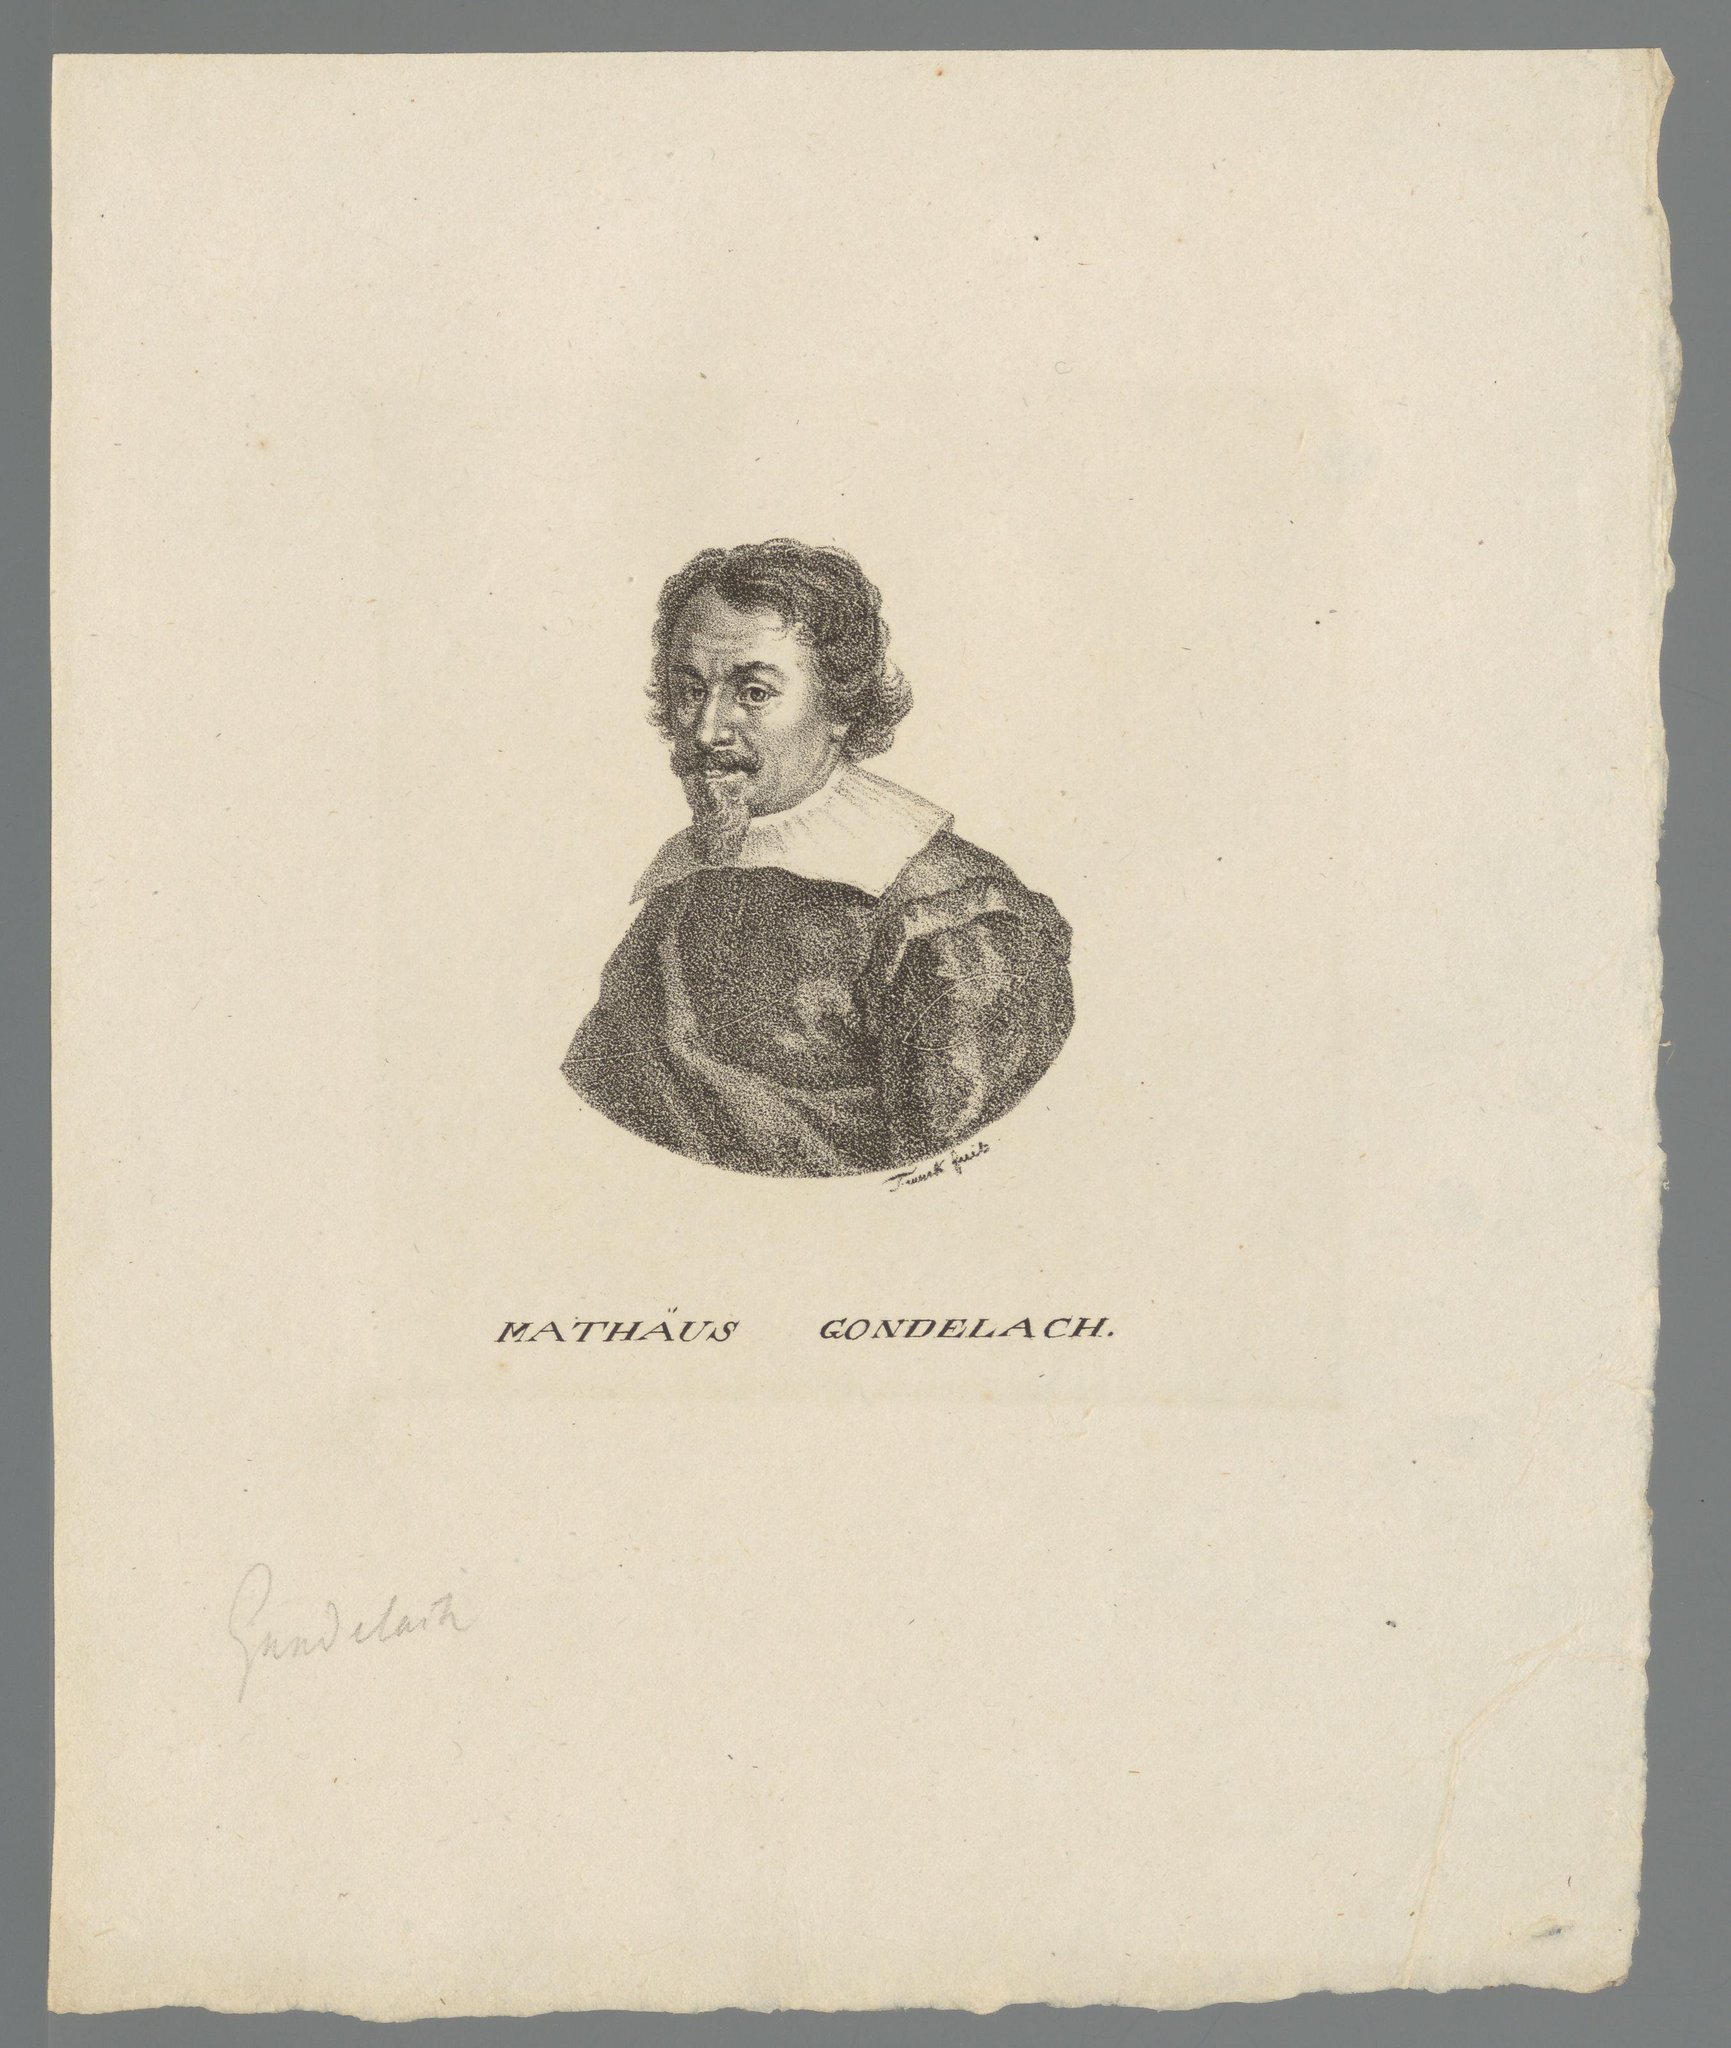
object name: book illustration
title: Portret van Matthäus Gundelach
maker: maximilian franck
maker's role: print maker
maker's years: 1780-1830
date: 1813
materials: paper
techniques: letterpress printing, lithograph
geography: munich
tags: augsburg, painter, matthäus gundelach, historical persons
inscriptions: collector's mark: Lugt 2228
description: Prent uit: Lindauer, Joseph. Deutsche Künstler-Gallerie. München: Maximilian Franck, 1813.